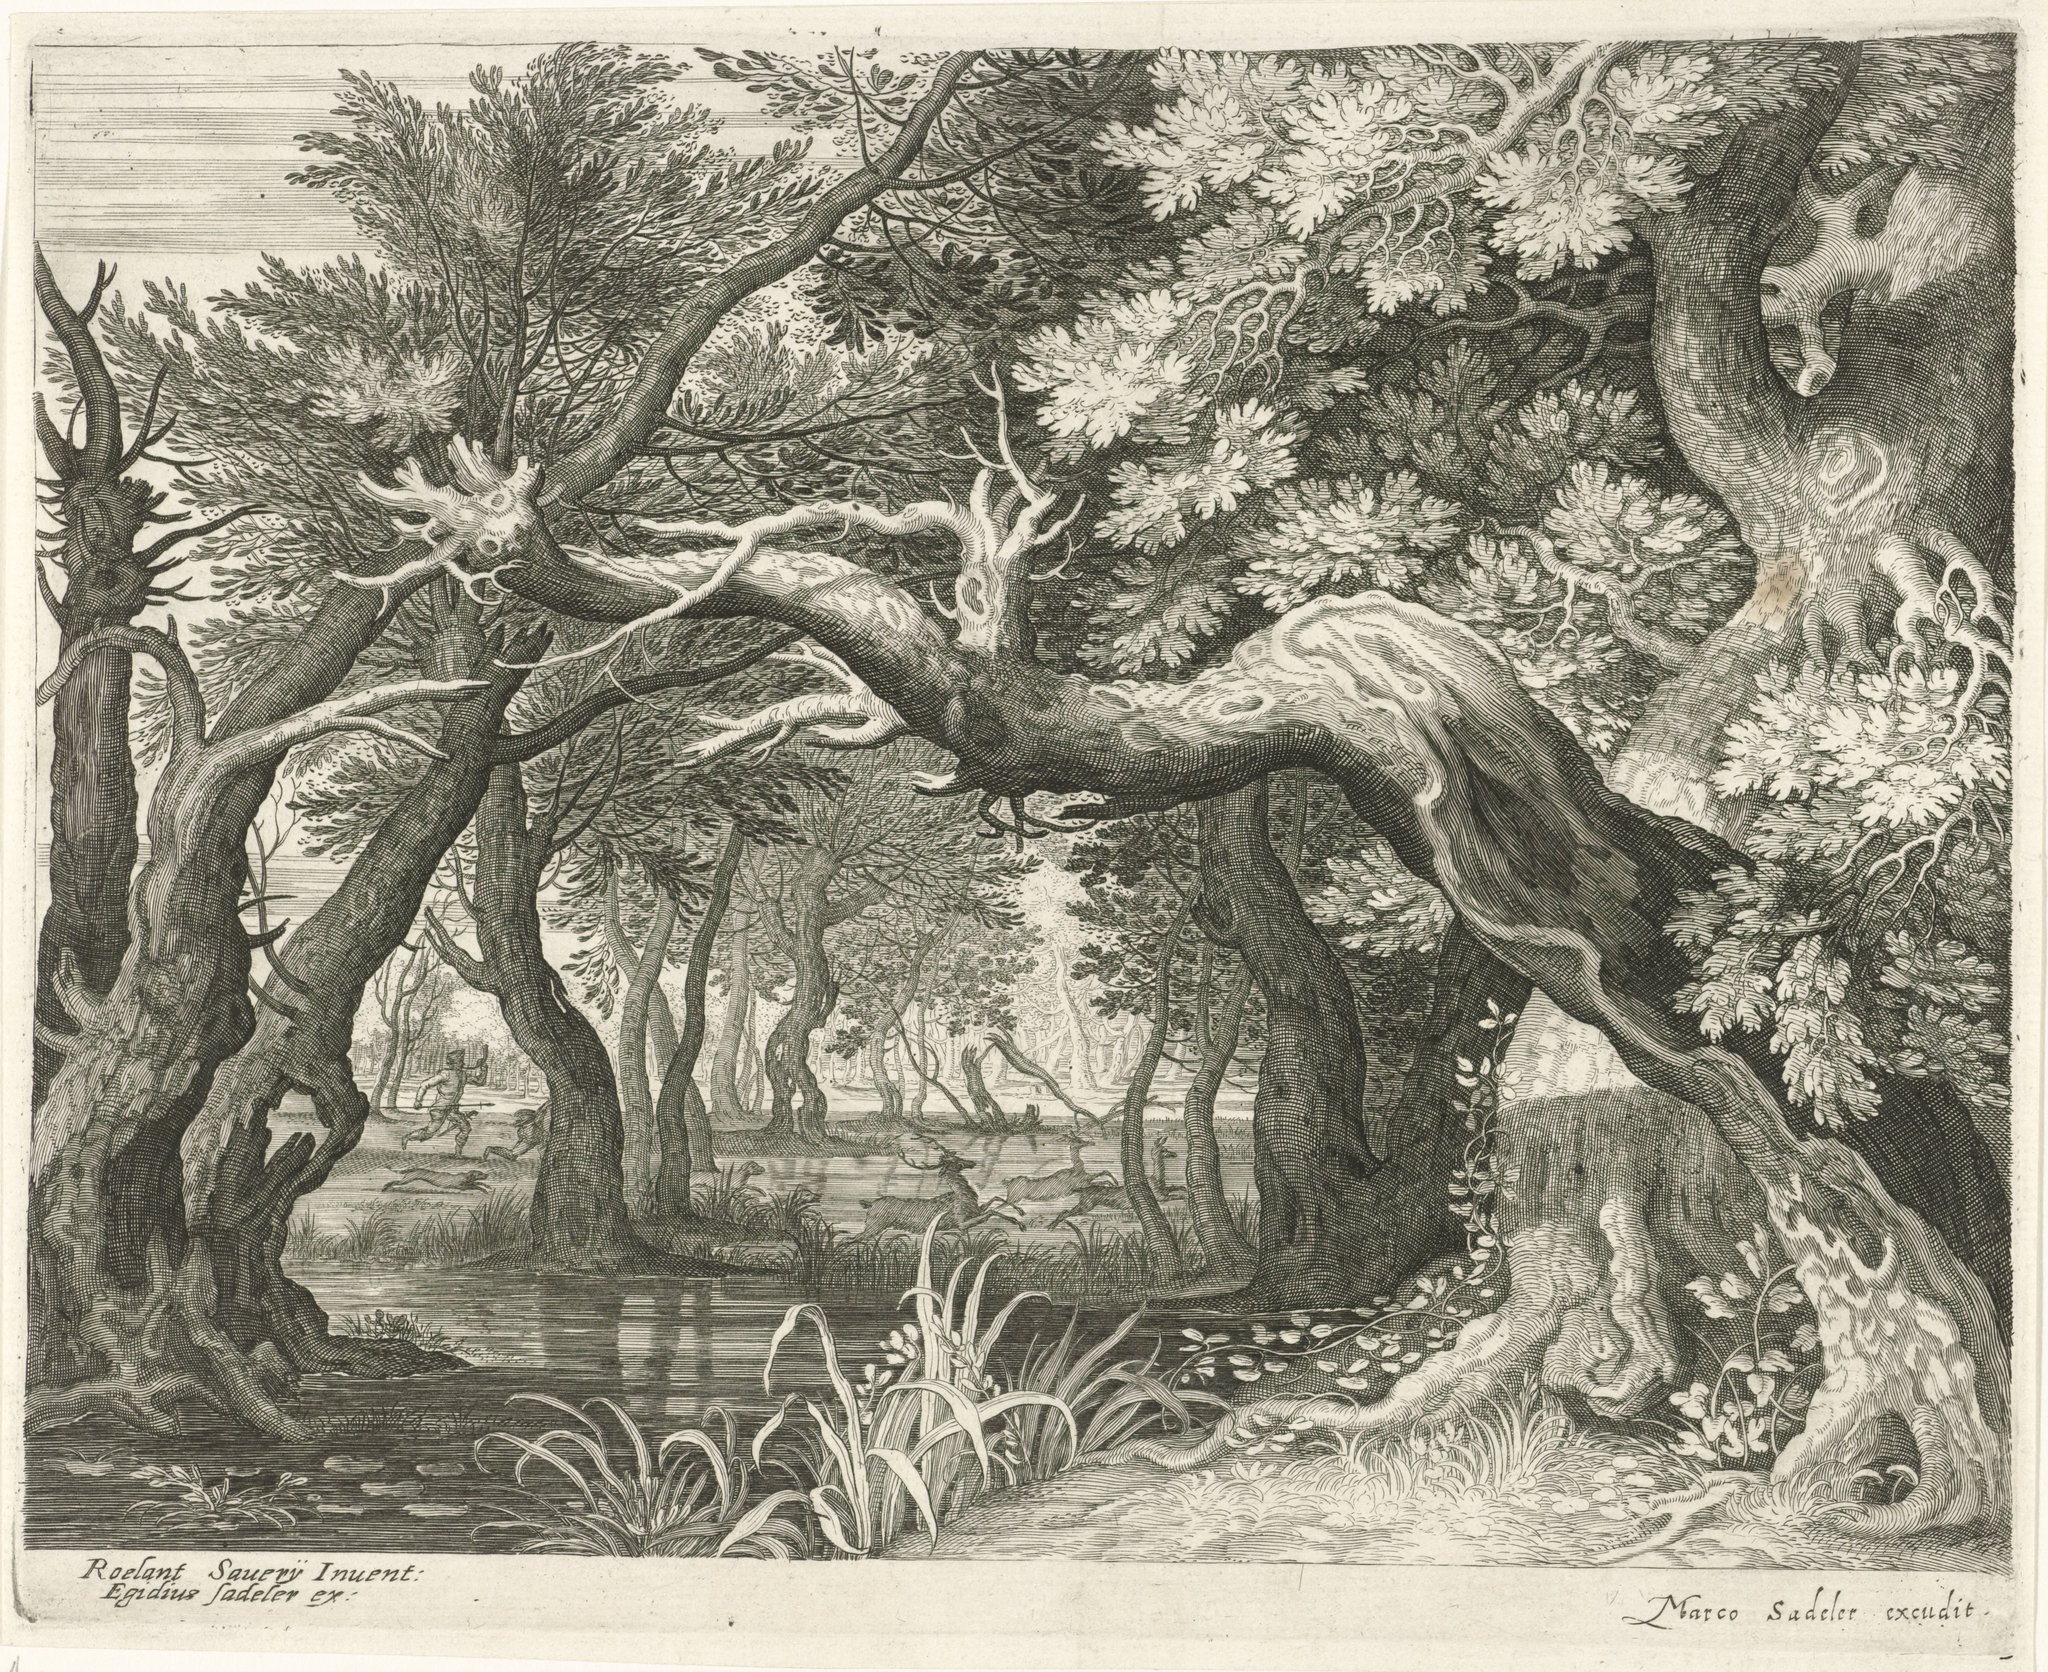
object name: print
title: Zes landschappen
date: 1597-1629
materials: paper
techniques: engraving, etching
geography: prague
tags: forest, wood, stag-hunting (+ hunting with dogs)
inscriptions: collector's mark: Lugt 2228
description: Bosmeer met zwaar overhangende bomen. Middenachter een hertenjacht. De derde prent in een zesdelige reeks met landschappen.